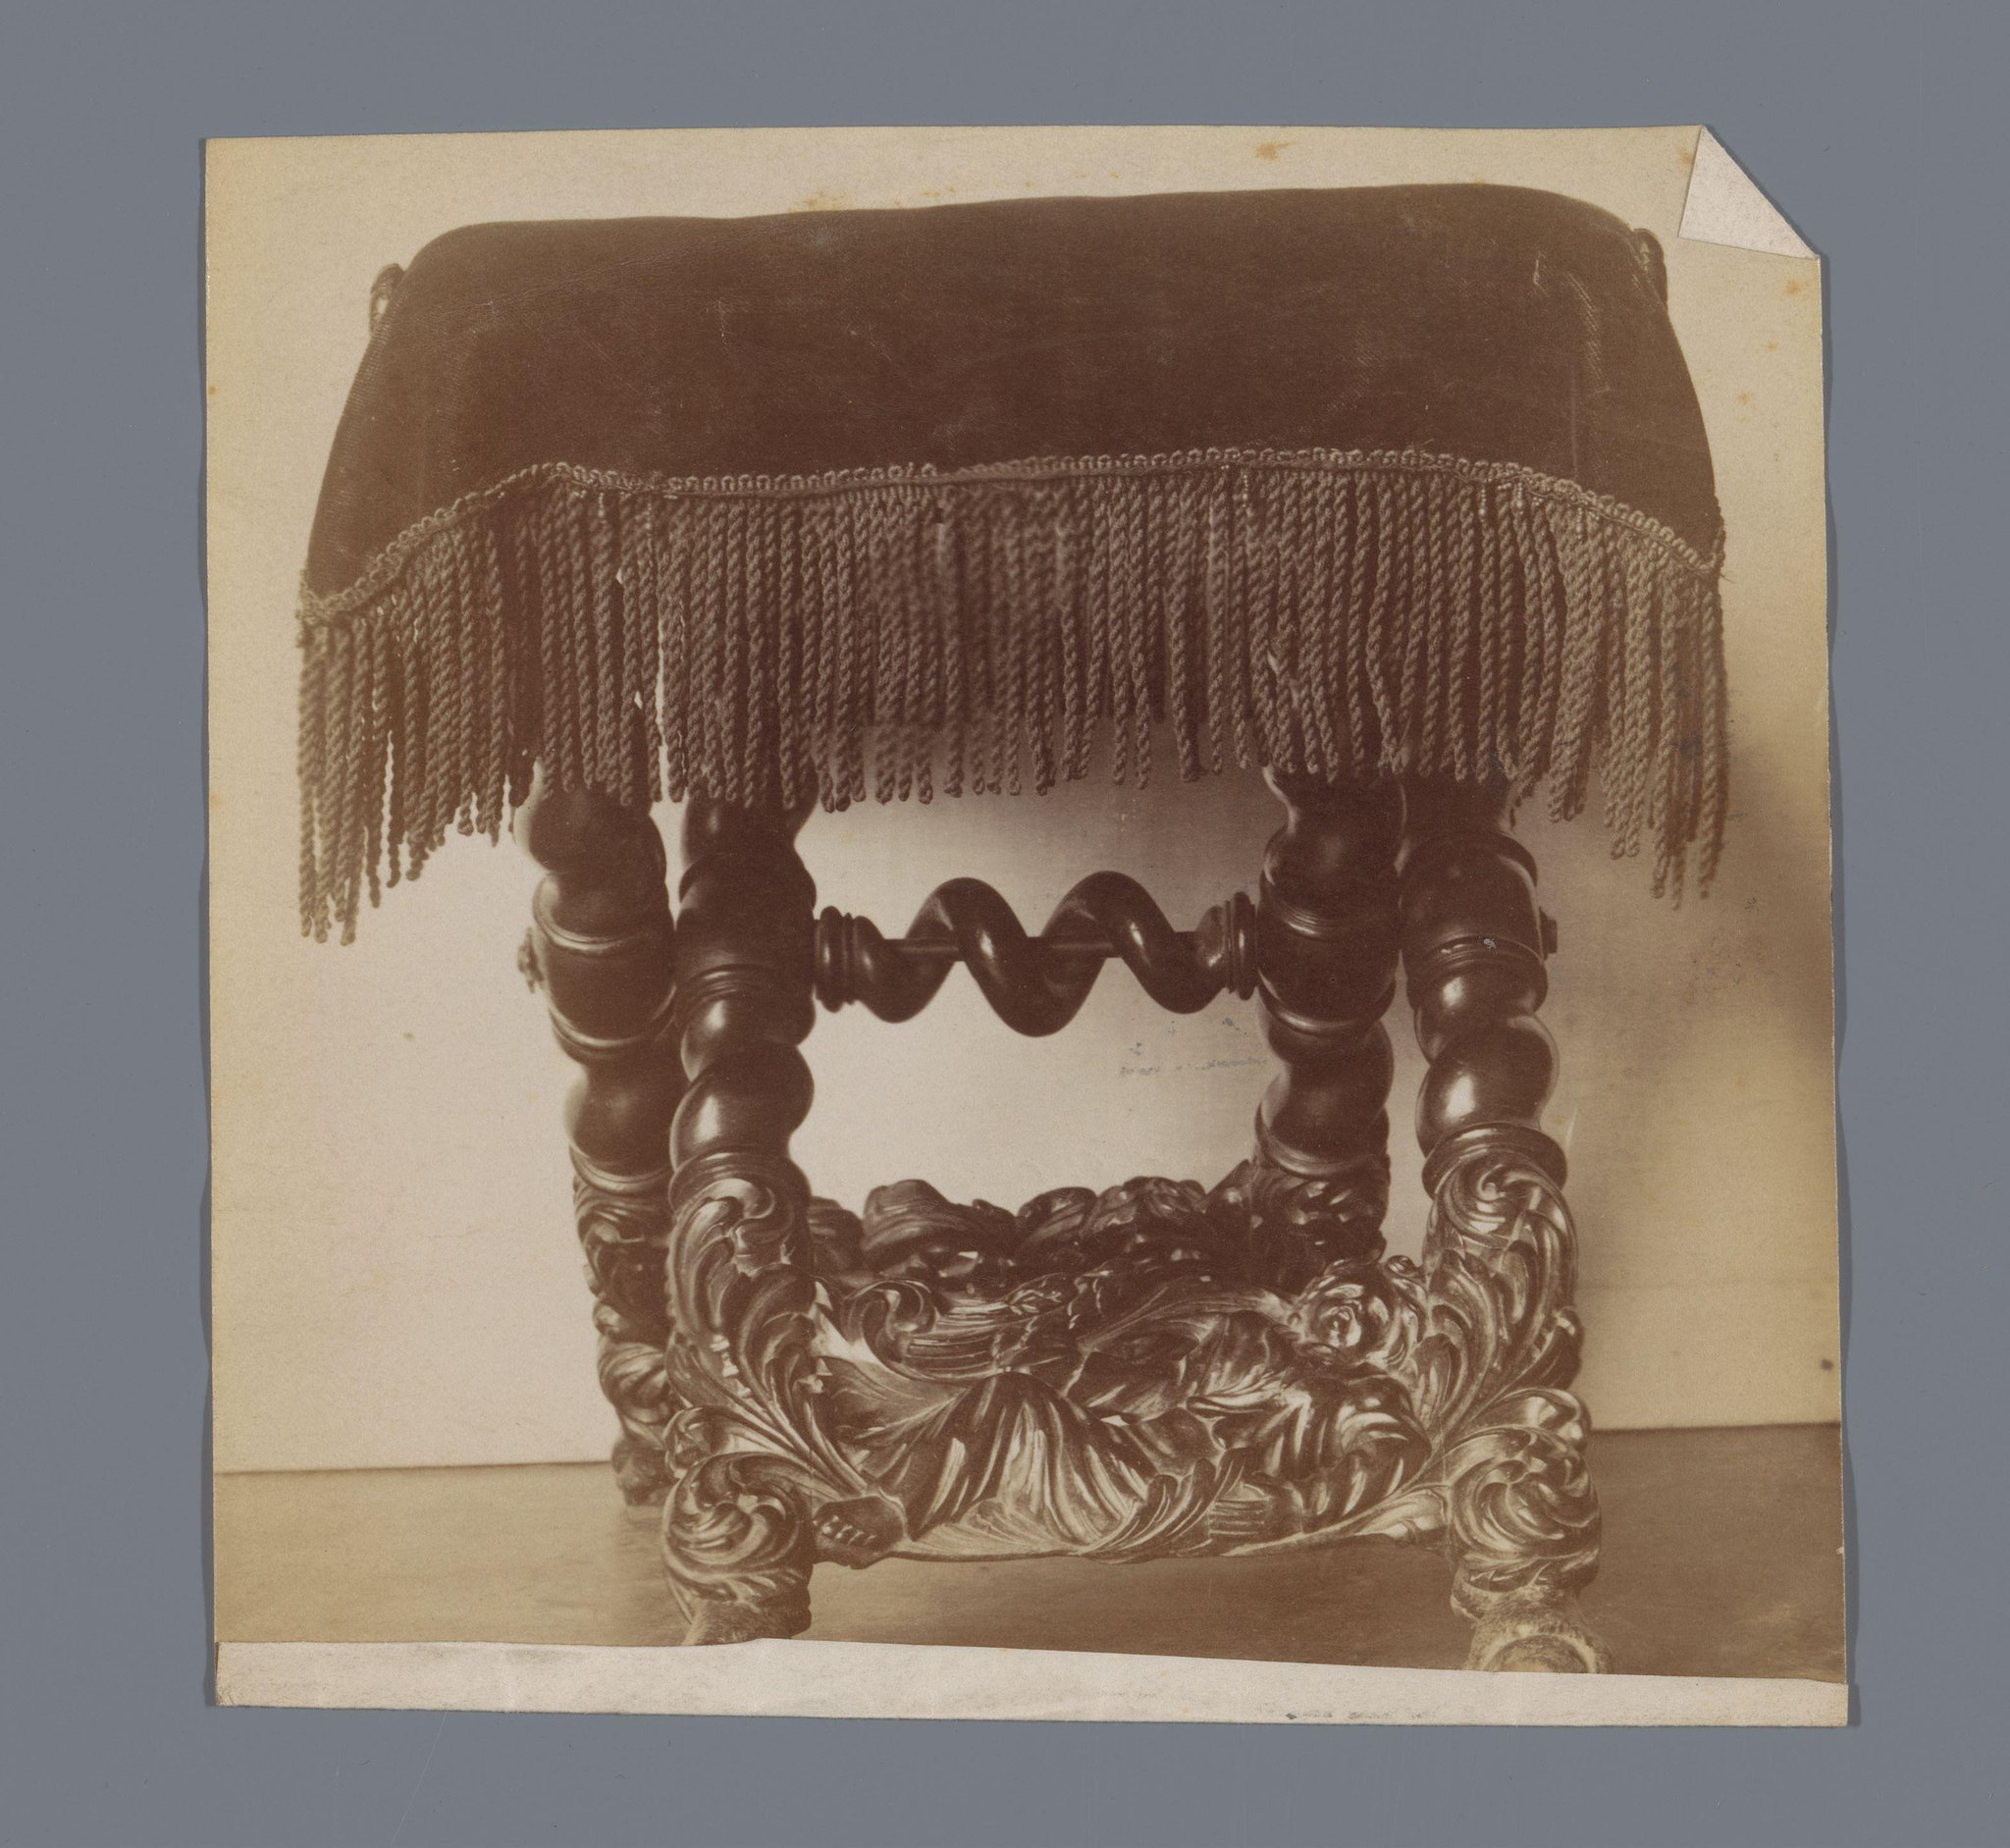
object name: photograph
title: Kruk met gedraaide poten gedecoreerd met bladmotieven en een liggende figuur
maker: Anonymous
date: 1875-1900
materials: photographic support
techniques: albumen print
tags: stool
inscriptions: number: ‘Vervalt’, collector's mark: ‘Instituut voor kunst-nijverheidsonderwijs Gabriël Metsustraat No. 16, Amsterdam’